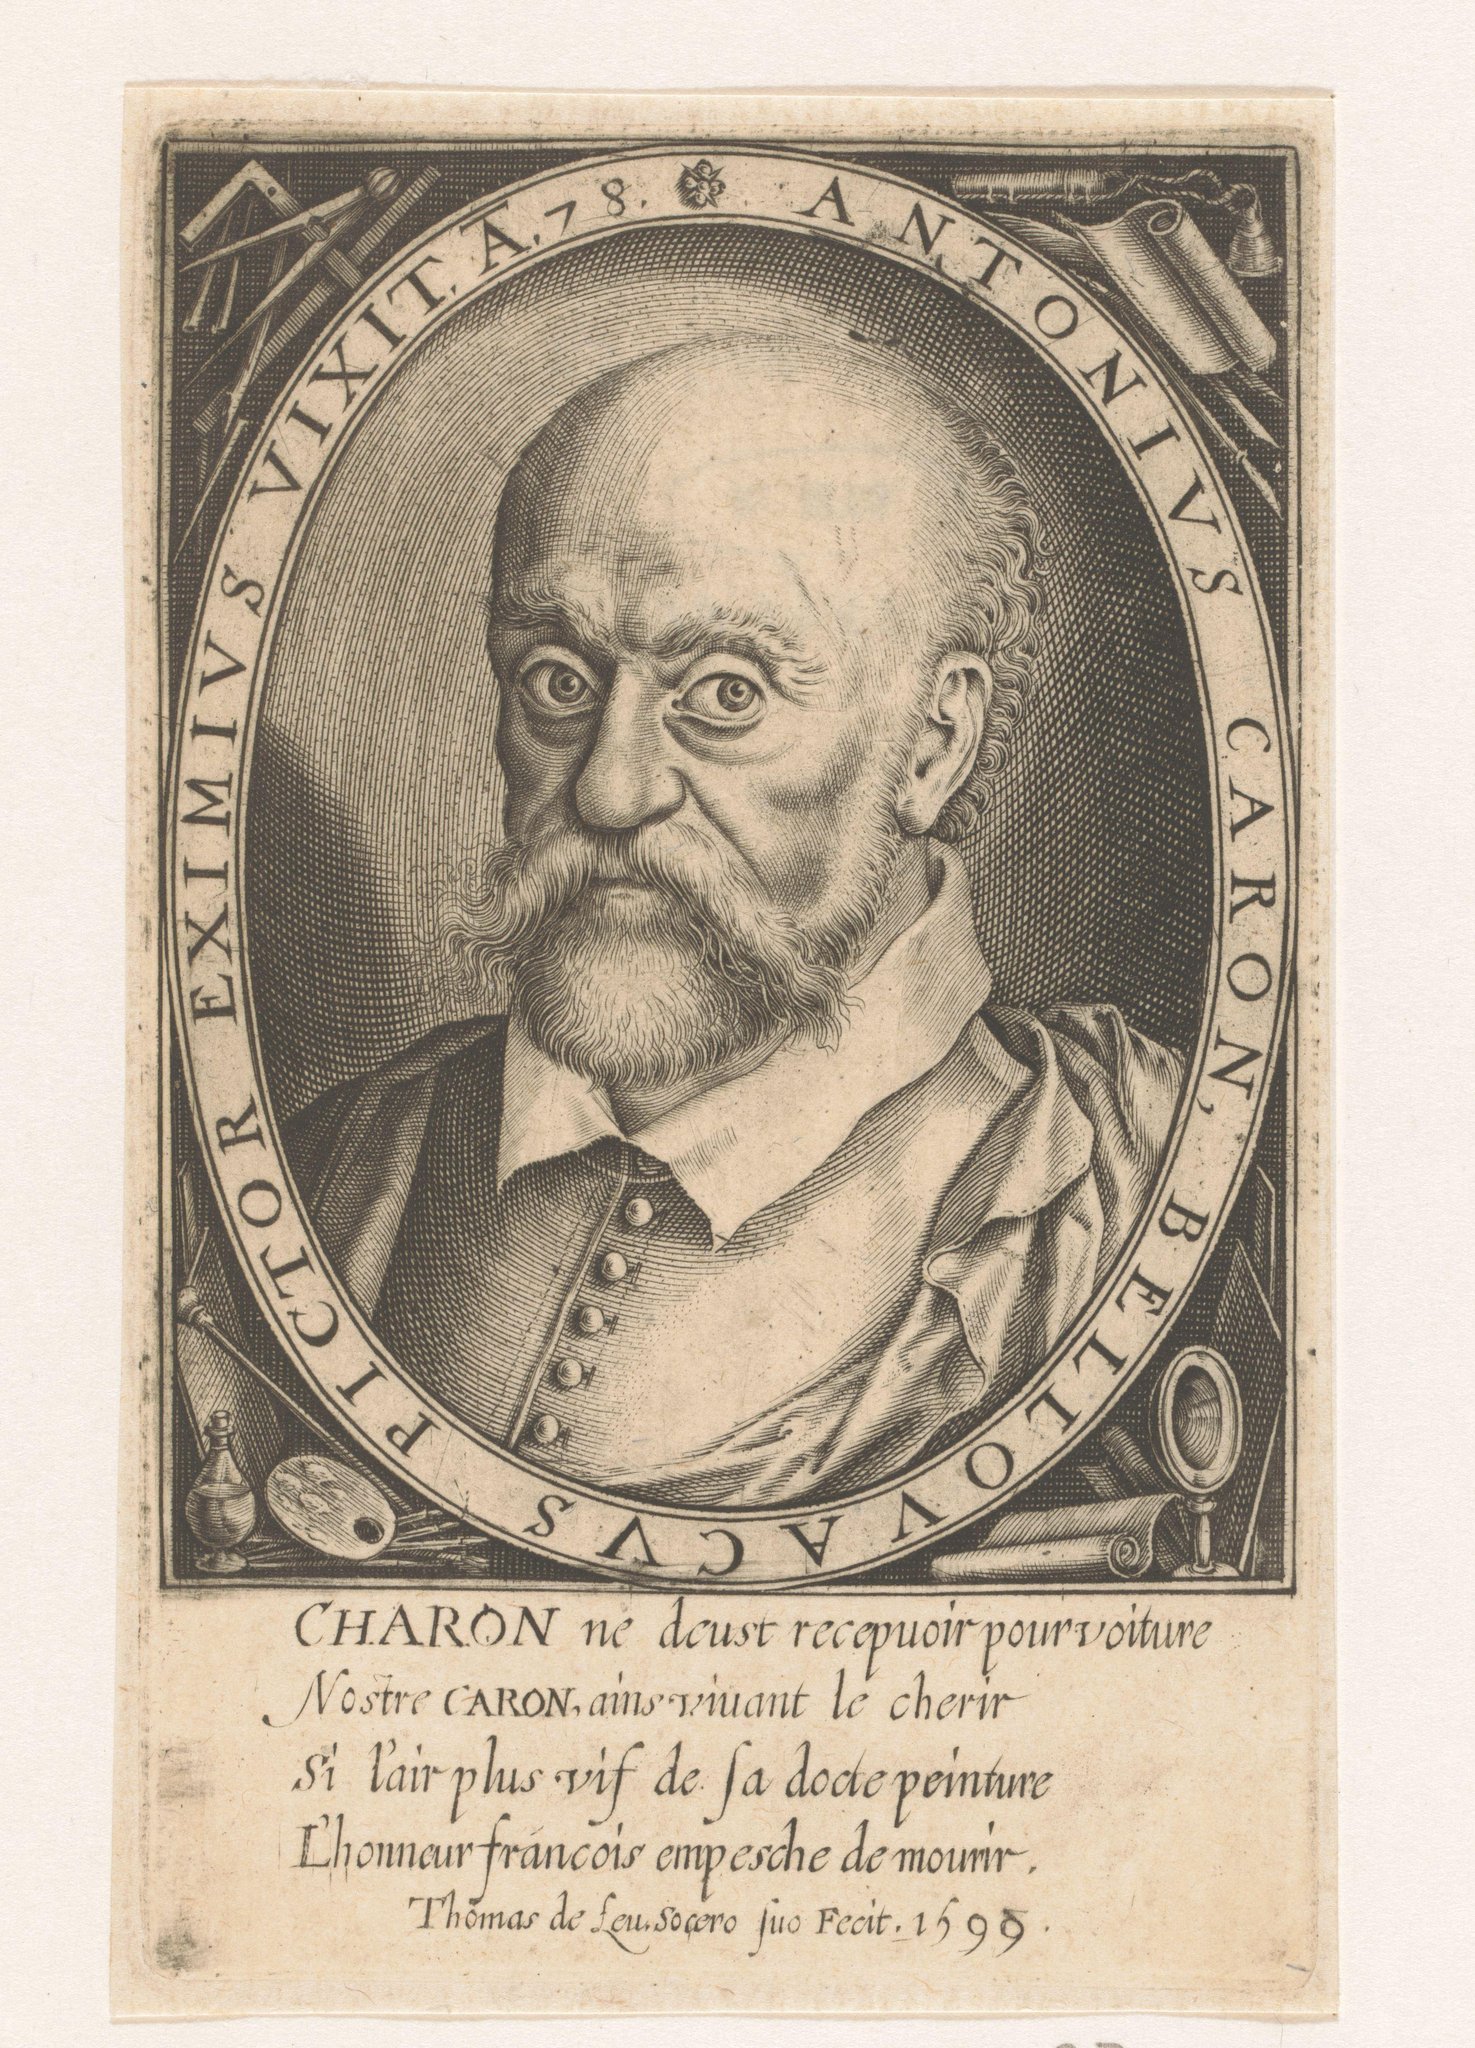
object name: print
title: Portret van Antoine Caron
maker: thomas de leu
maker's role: print maker, publisher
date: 1599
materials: paper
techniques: engraving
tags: painter, antoine caron, historical persons, portrait, self-portrait of painter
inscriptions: collector's mark: Lugt 2228